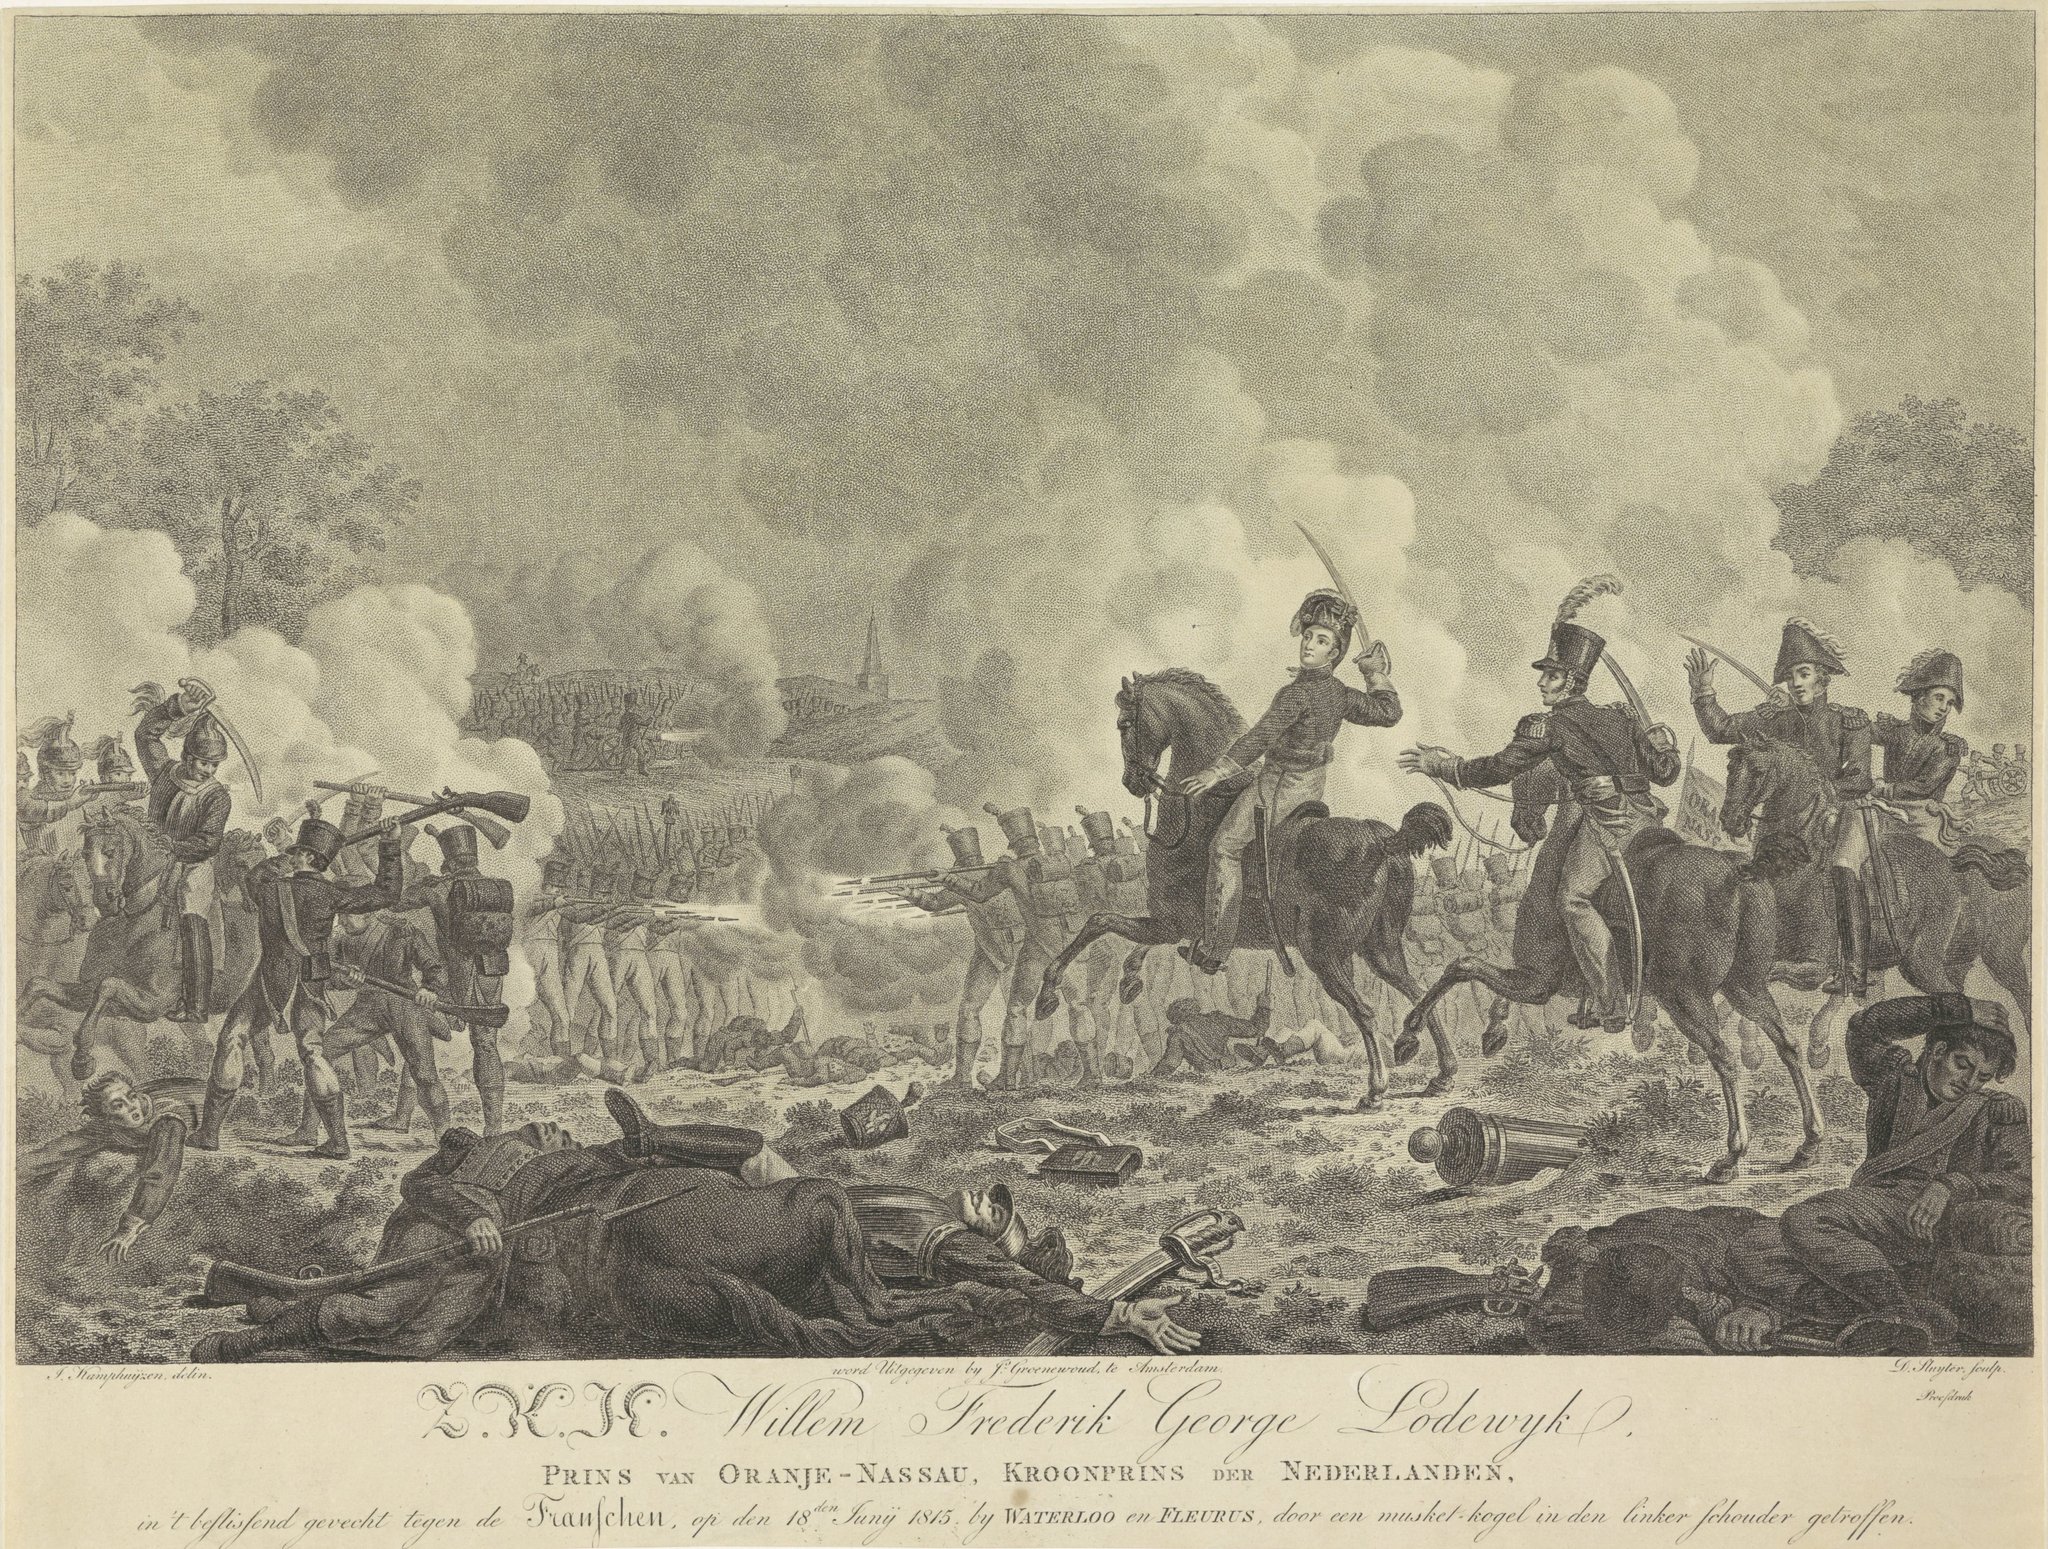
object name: print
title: Tweede serie van vier platen van de veldslagen bij Quatre-Bras en Waterloo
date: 1815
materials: paper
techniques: etching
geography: amsterdam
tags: the hague, william ii of the netherlands, putting out of action by wounding, battle (+ land forces), waterloo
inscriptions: collector's mark: Lugt 2228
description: Prins Willem Frederik George op het moment dat hij gewond raakt tijdens de Slag bij Waterloo op 18 juni 1815. Links en op de achtergrond zware gevechten tussen de Nederlanders en Fransen. Rechts enkele officieren te paard.